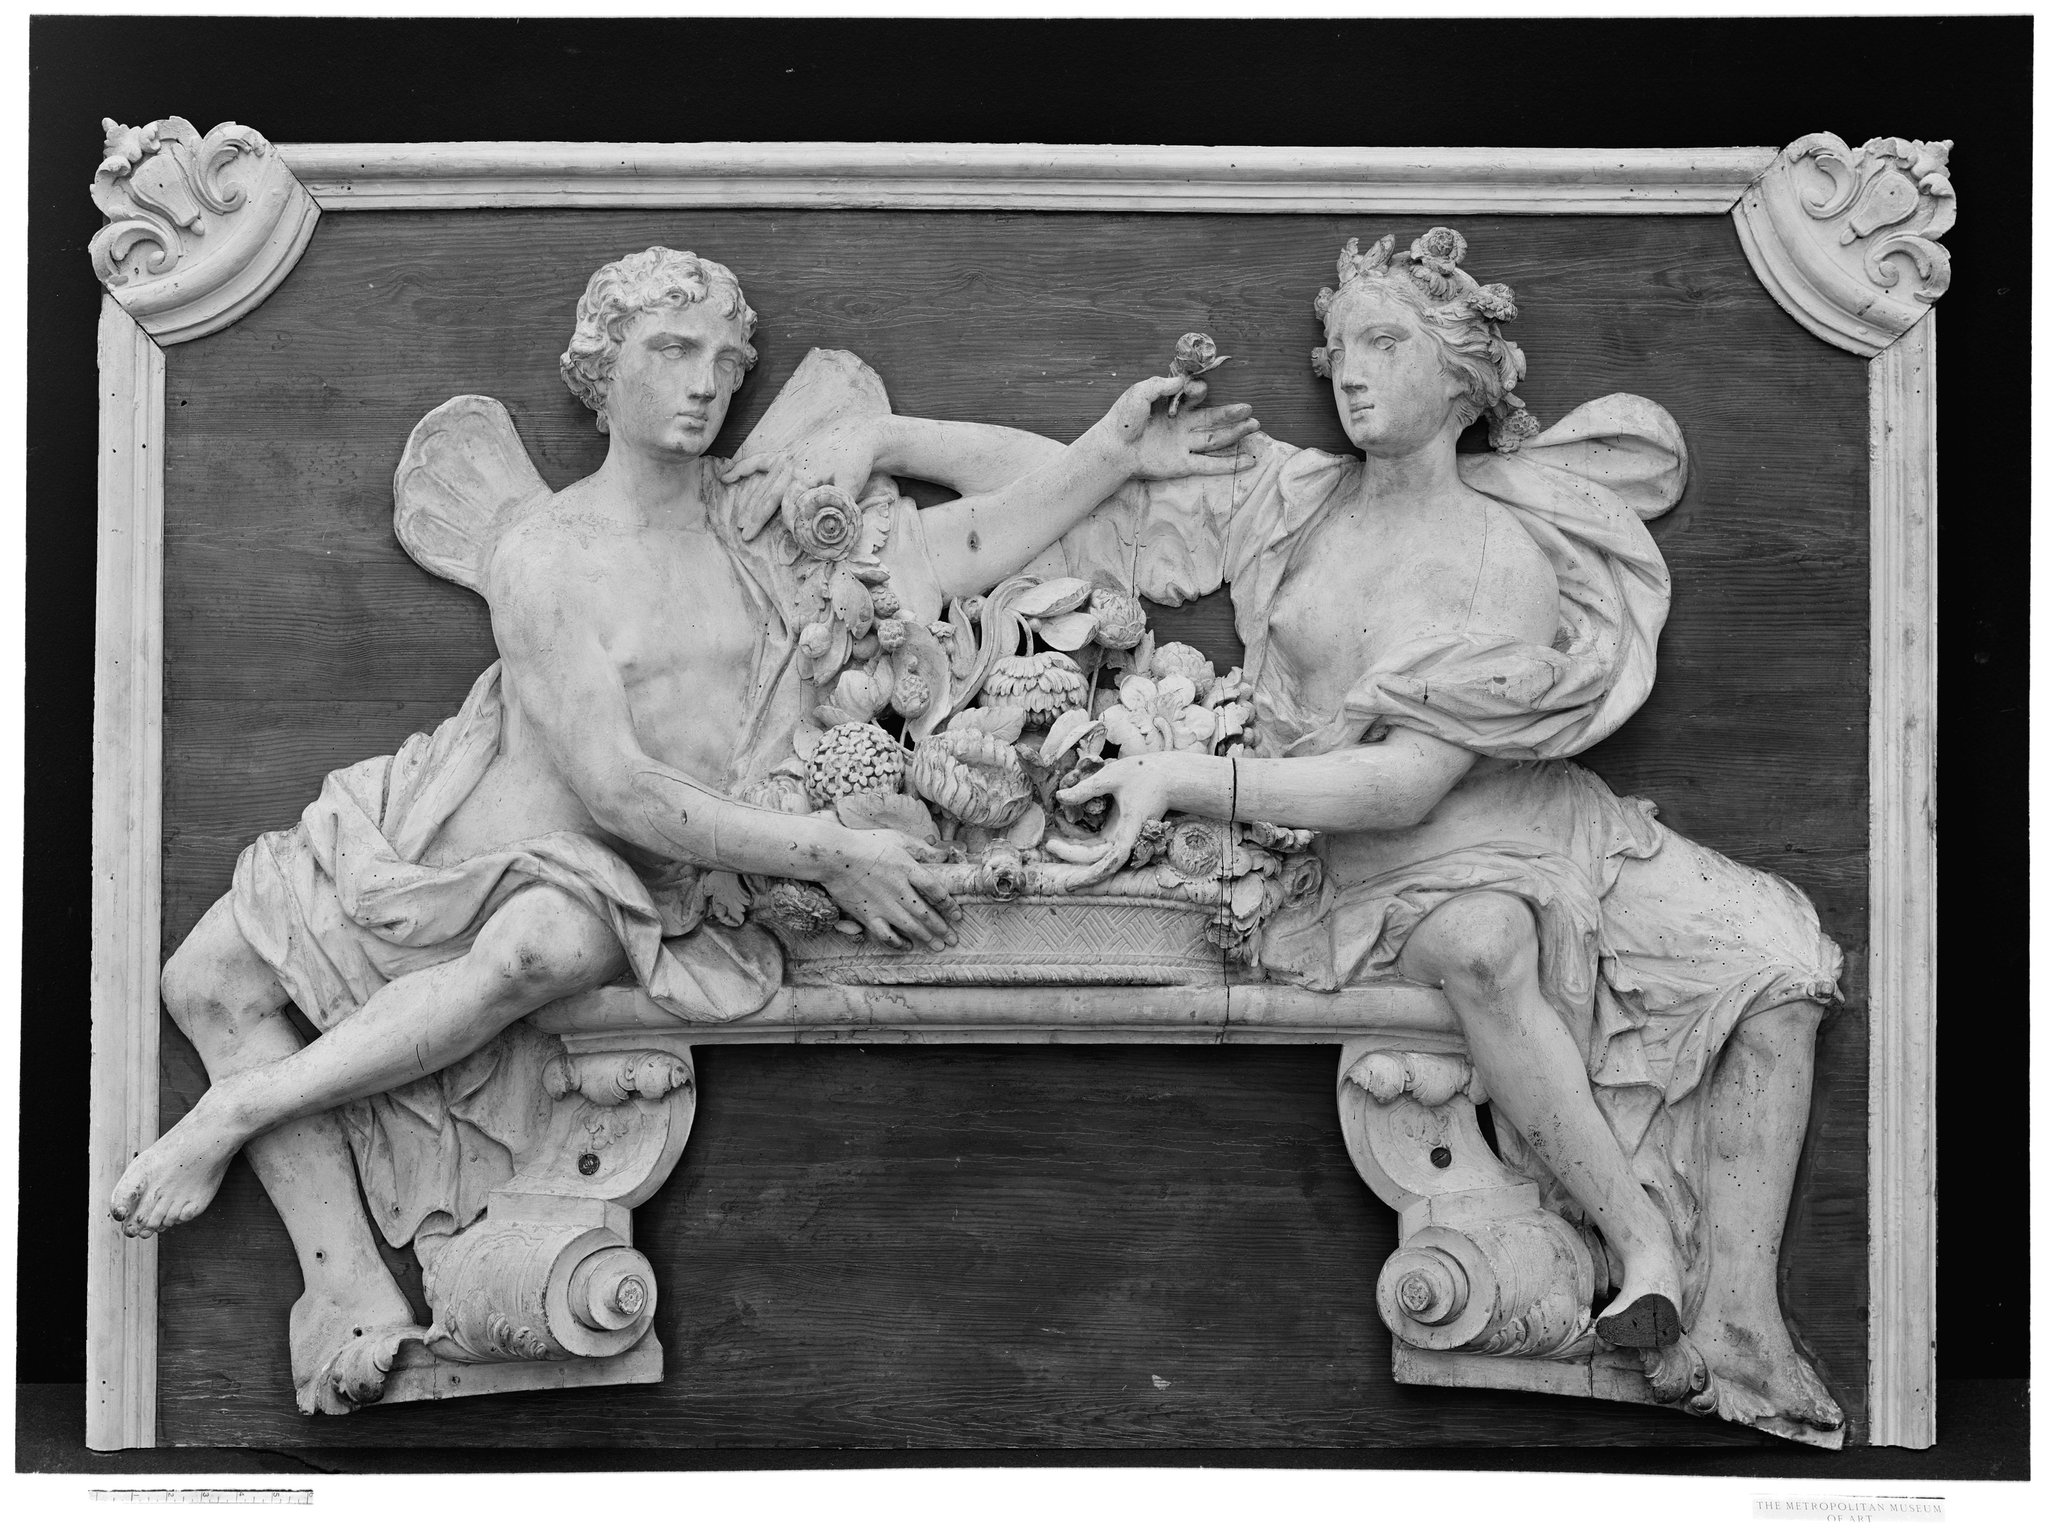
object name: overdoor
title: Overdoor (Dessus de porte)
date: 1726-1750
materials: wood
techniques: carving, painting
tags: men,women,flowers